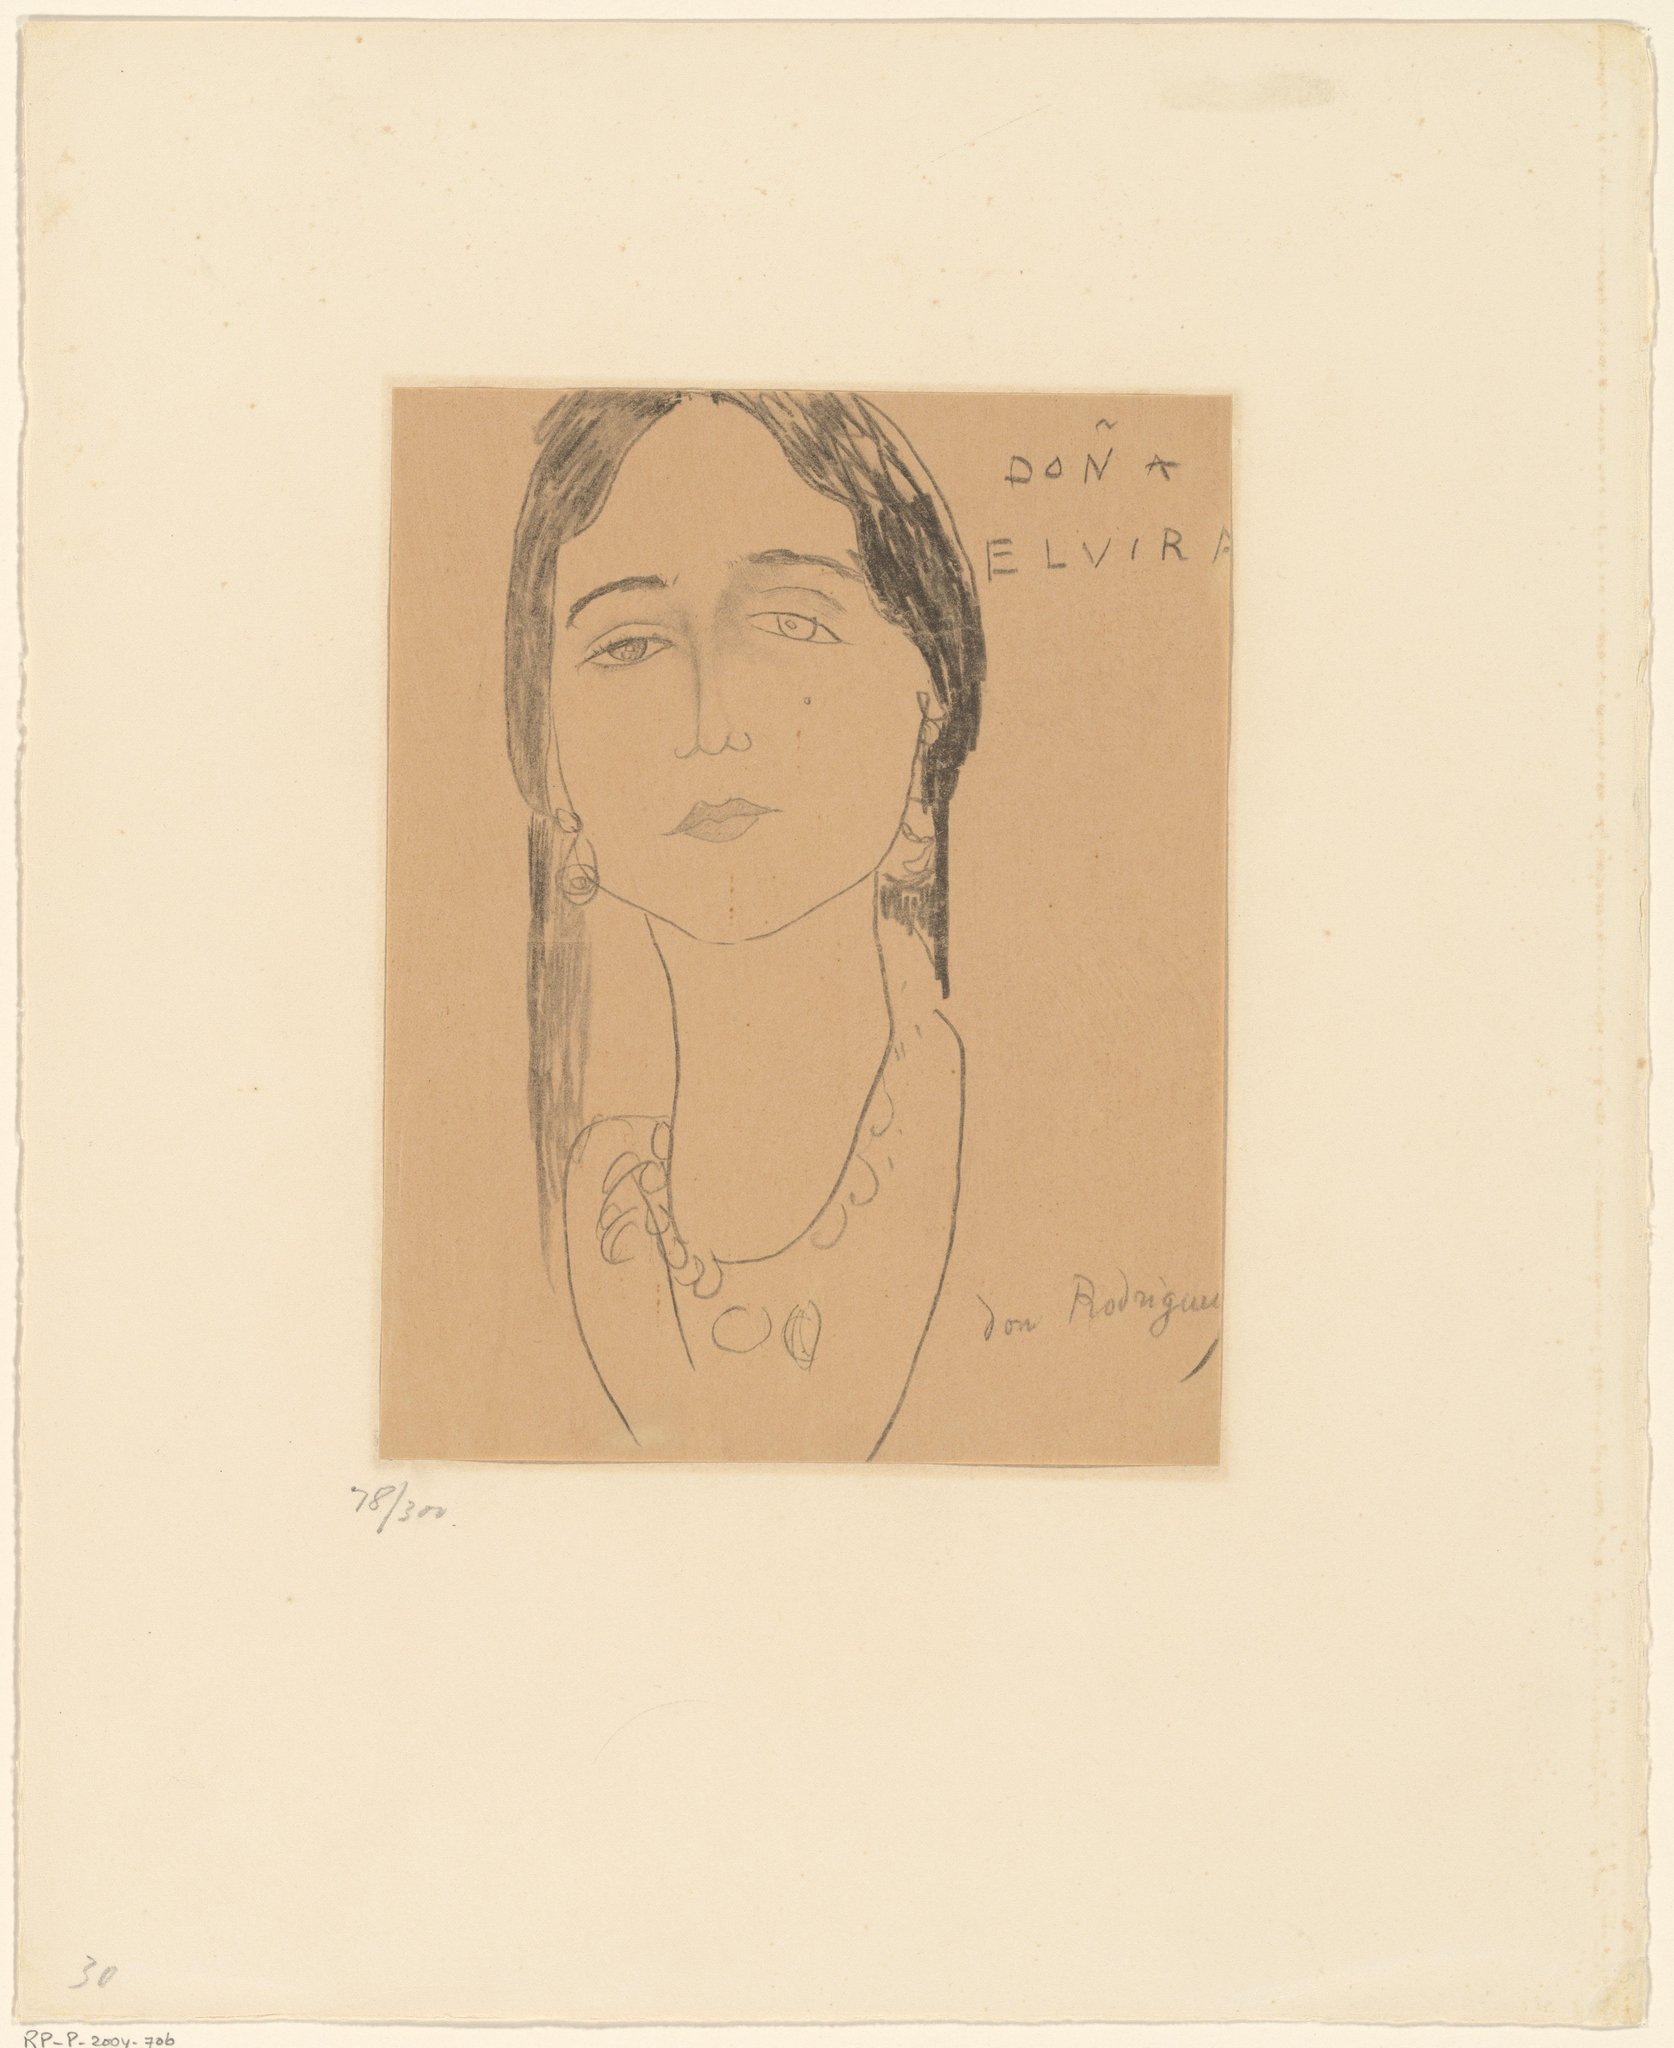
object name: print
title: Doña Elvira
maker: Anonymous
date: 1894-2004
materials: paper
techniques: lithograph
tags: historical persons, head (human) - aa - female human figure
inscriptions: collector's mark: Lugt 2228